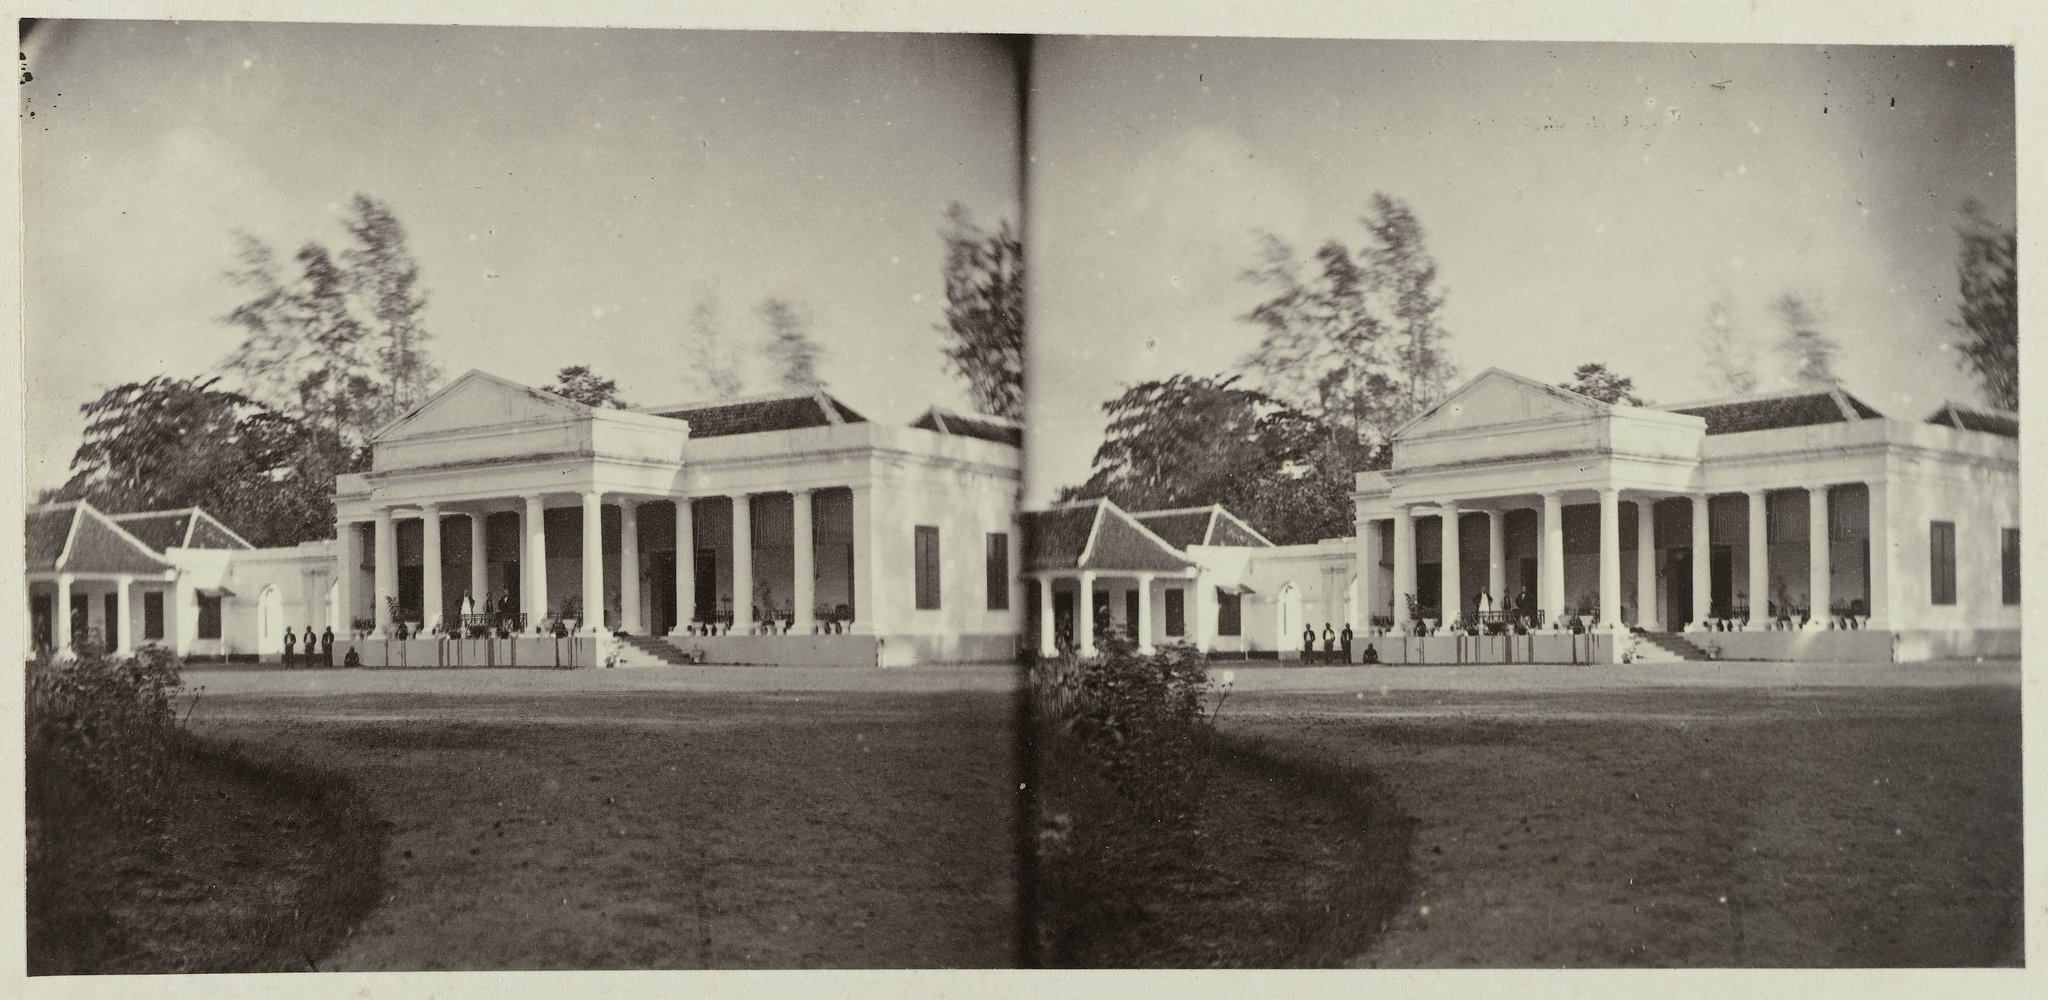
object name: stereograph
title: Officieel gebouw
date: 1863-1869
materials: photographic support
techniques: albumen print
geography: java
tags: colonial government, java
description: Stereofoto van een groot officieel gebouw. Onderdeel van het groene fotoalbum met foto's van Java, uit het bezit van apotheker Specht-Grijp, die in 1865 vanuit Batavia naar Nederland terugkeerde.